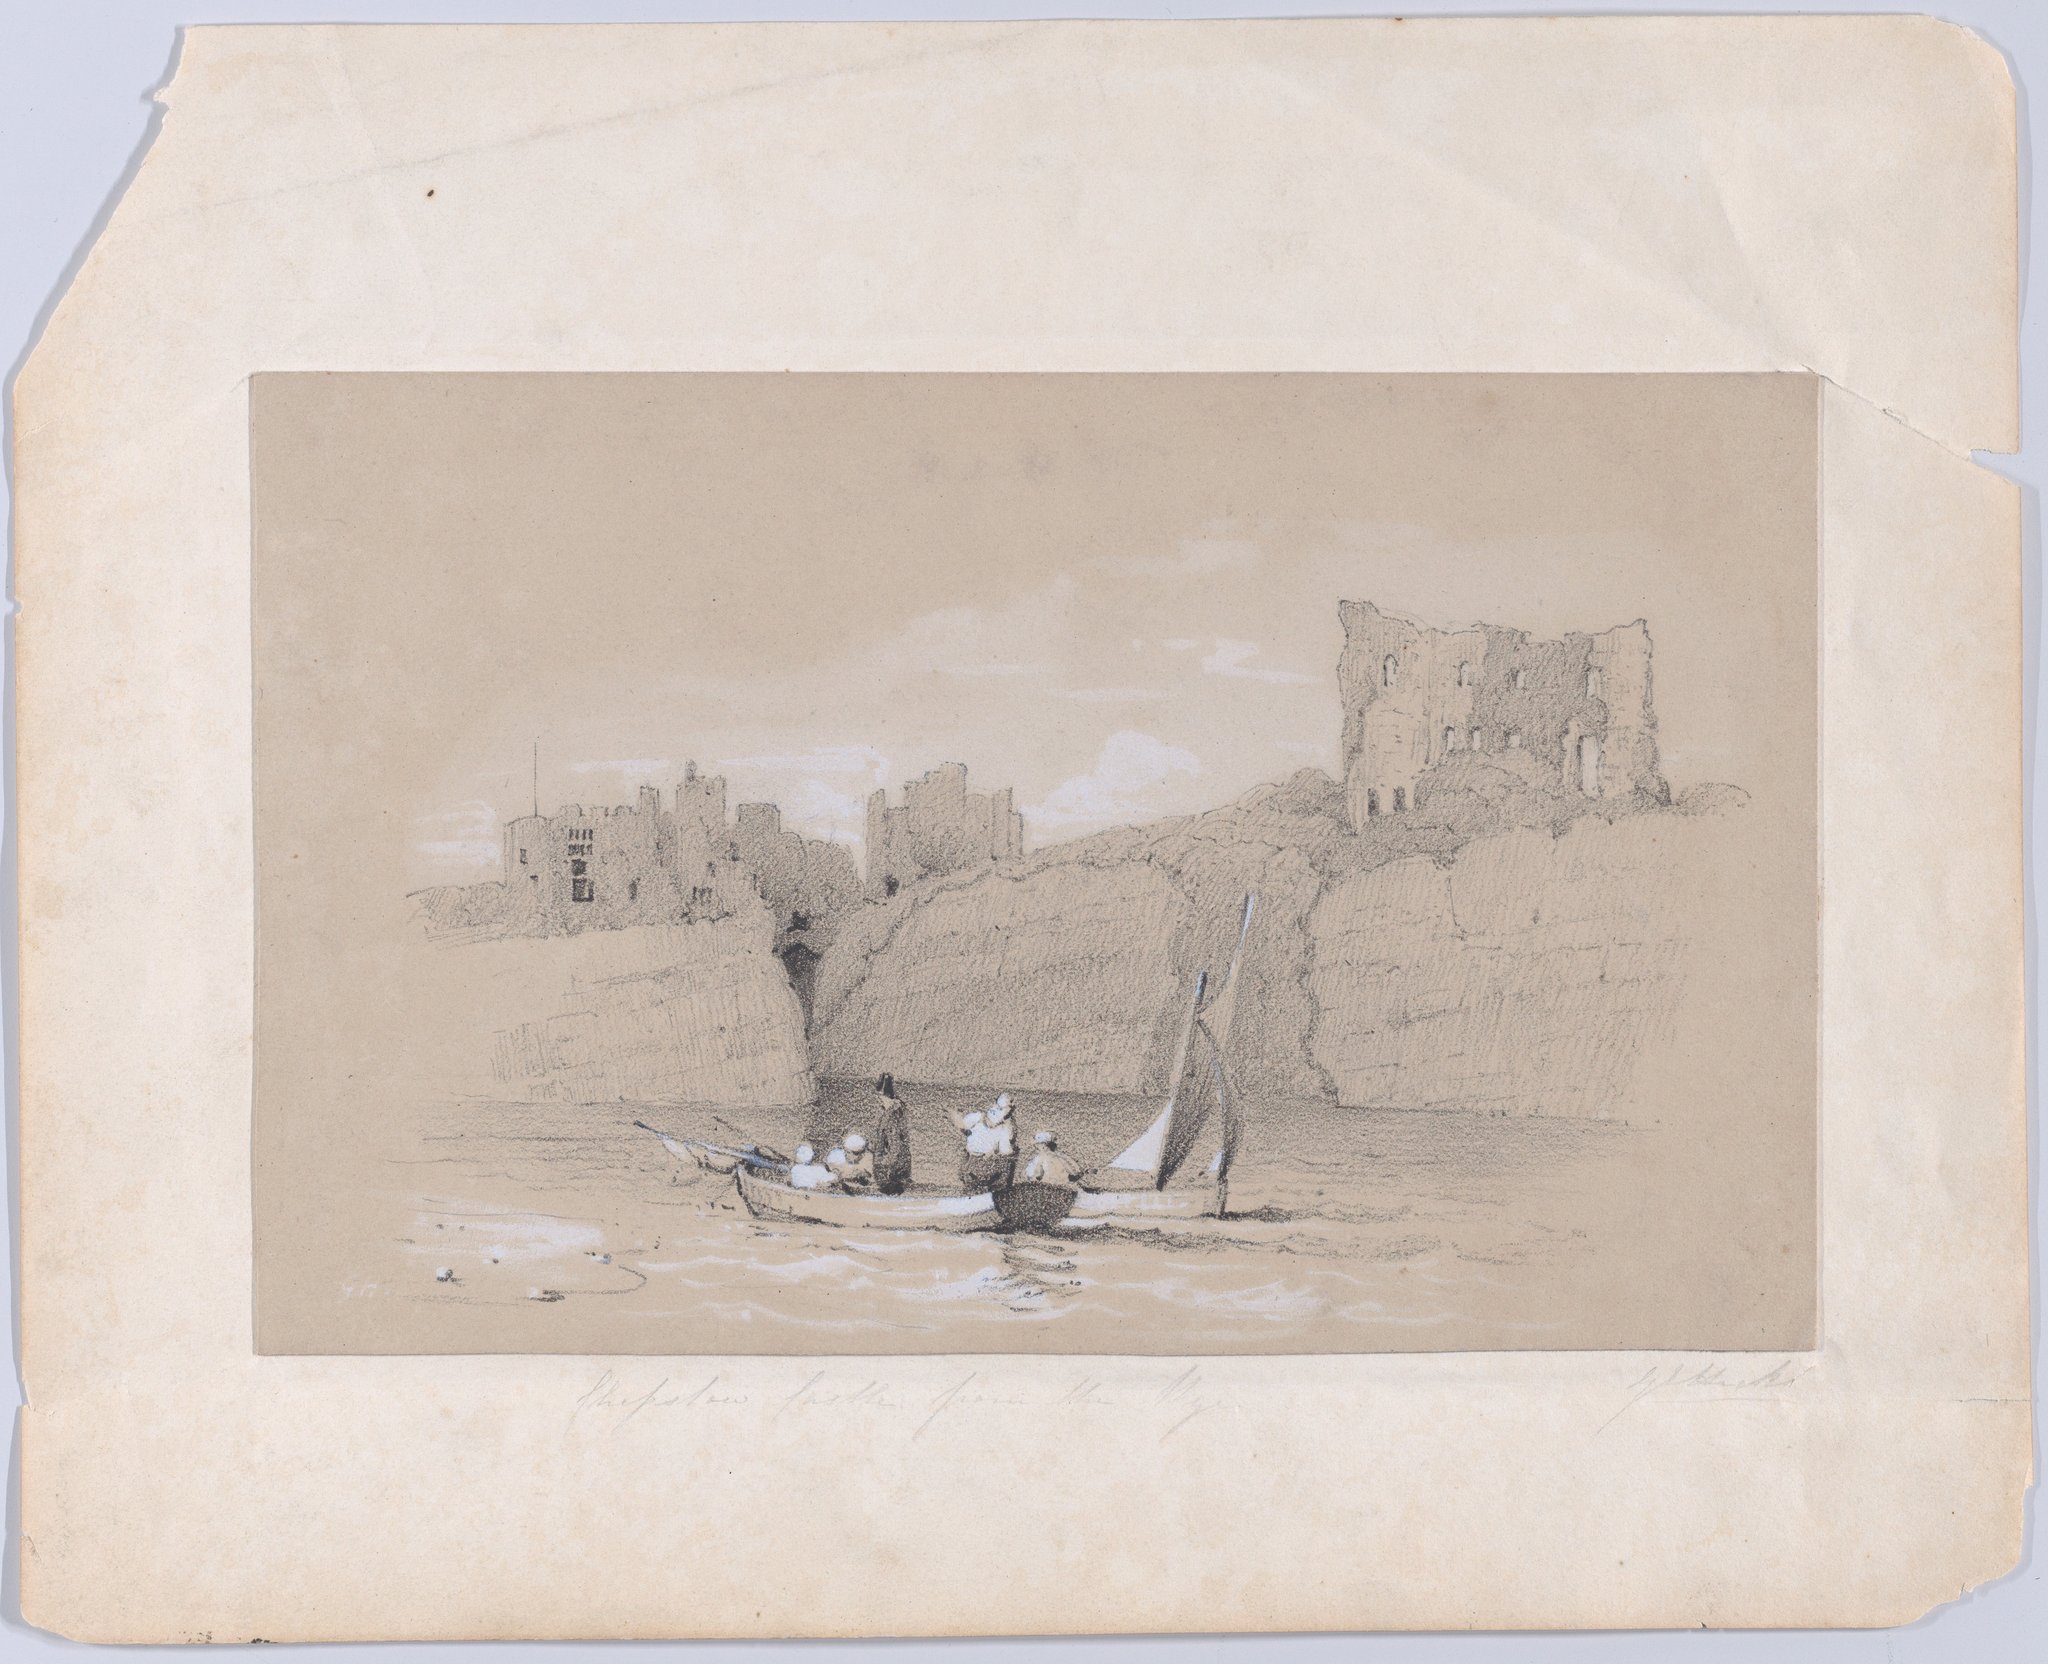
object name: drawing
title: Chepstow Castle, Wales from the river Wye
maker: lilburne hicks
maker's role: artist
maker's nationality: british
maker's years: 1814-1861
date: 1830-1860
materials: chalk, crayon